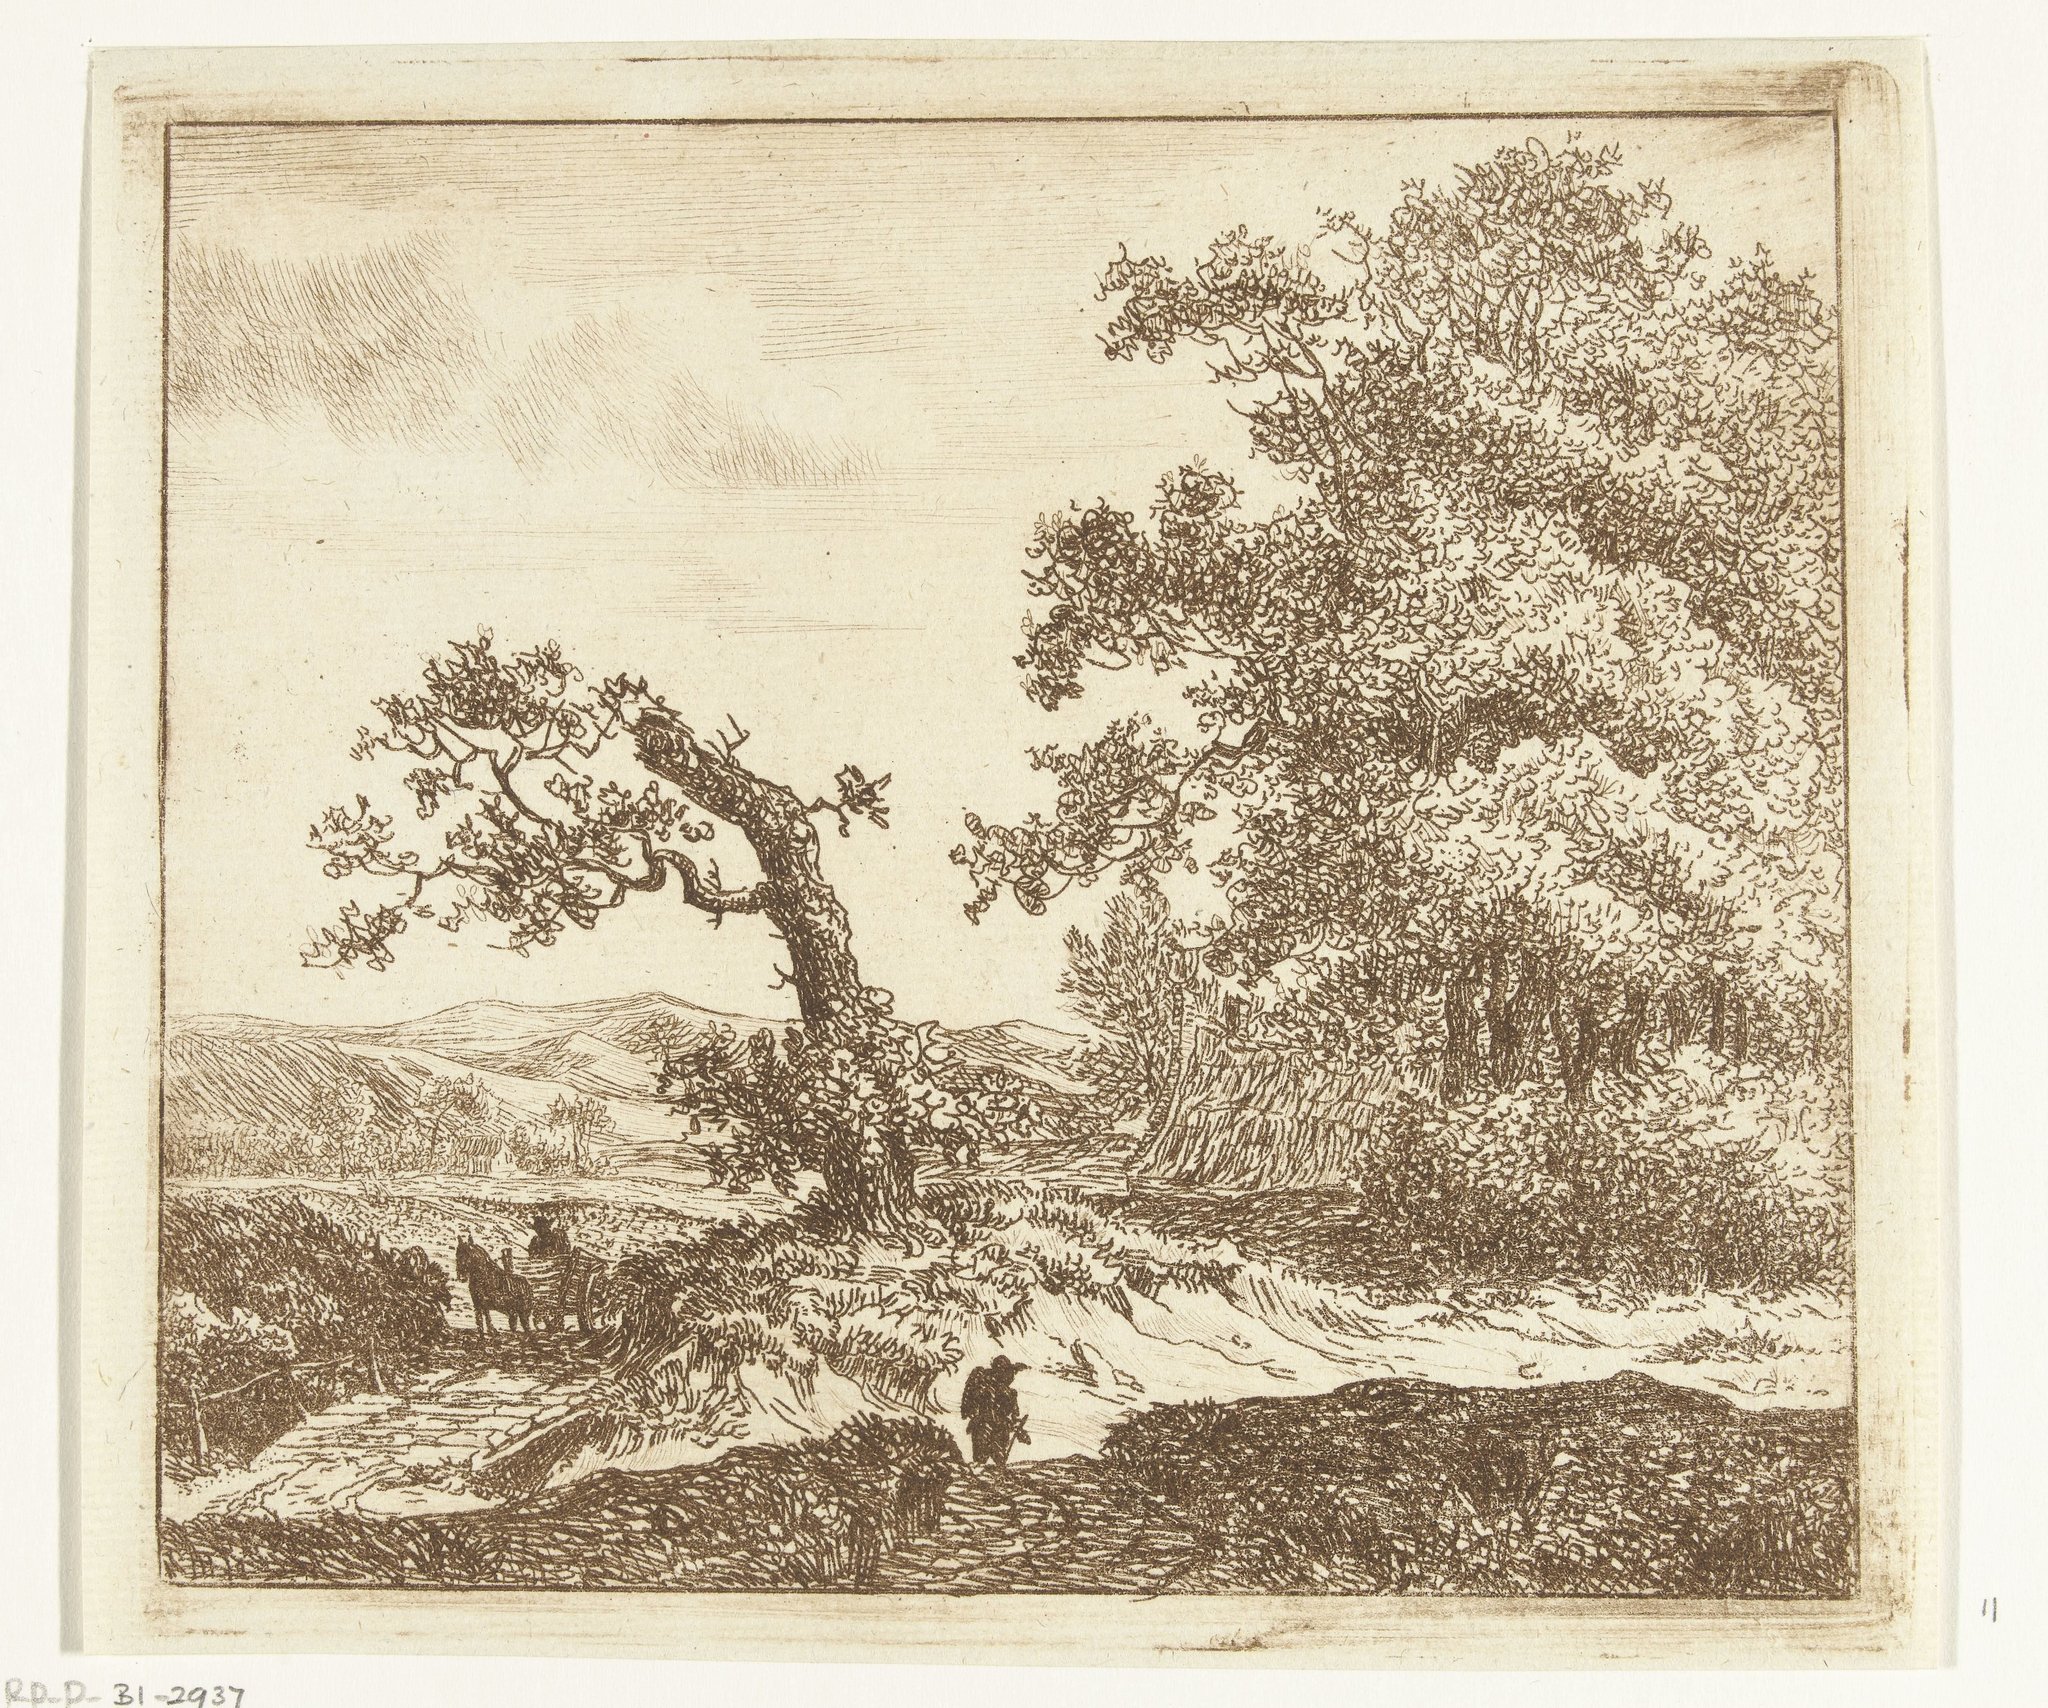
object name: print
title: Wandelaar in de duinen buiten Haarlem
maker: anthonie van den bos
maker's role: draughtsman, print maker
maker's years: 1763-1838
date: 1778-1838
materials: paper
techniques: drypoint, etching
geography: netherlands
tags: dunes (sea not visible); in the dunes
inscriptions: collector's mark: Lugt 2228